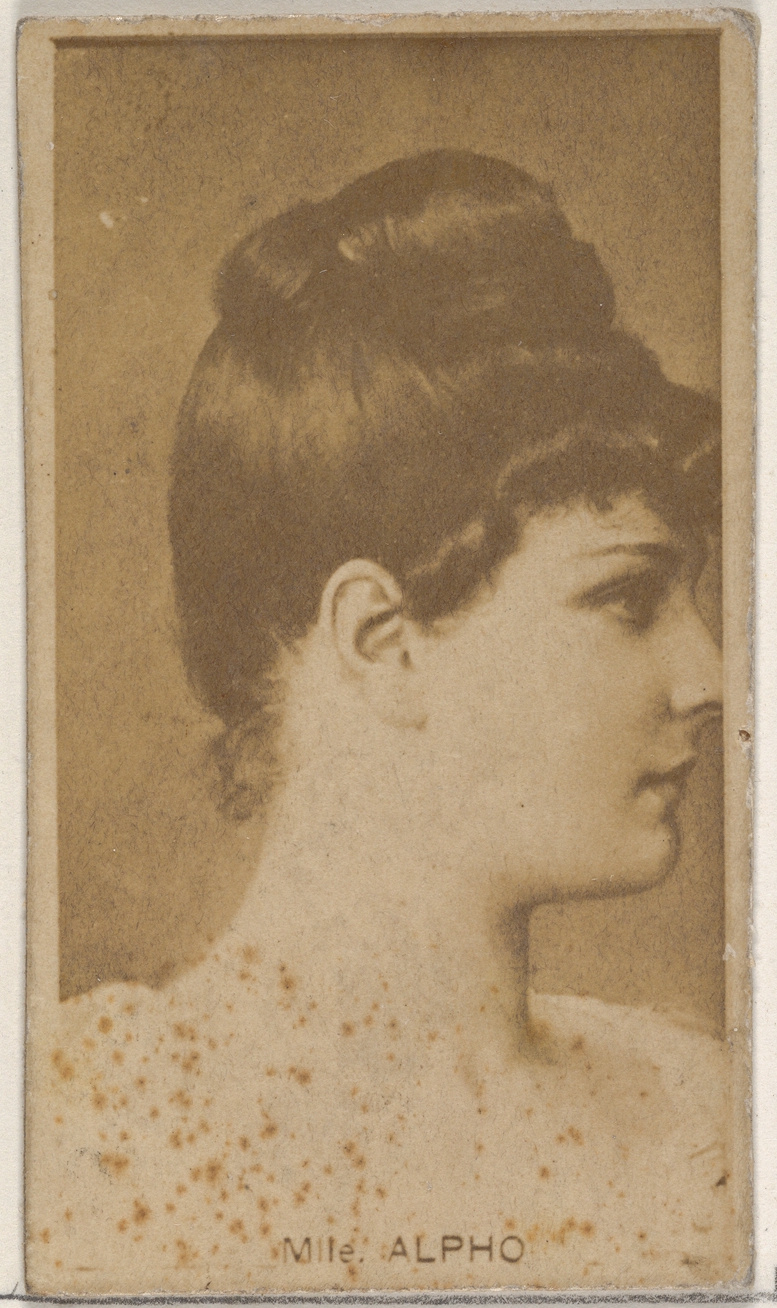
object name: photograph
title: Mlle. Alpho, from the Actors and Actresses series (N45, Type 8) for Virginia Brights Cigarettes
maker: allen & ginter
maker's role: publisher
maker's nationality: american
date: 1888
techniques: albumen silver print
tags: portraits,profiles,women,actresses